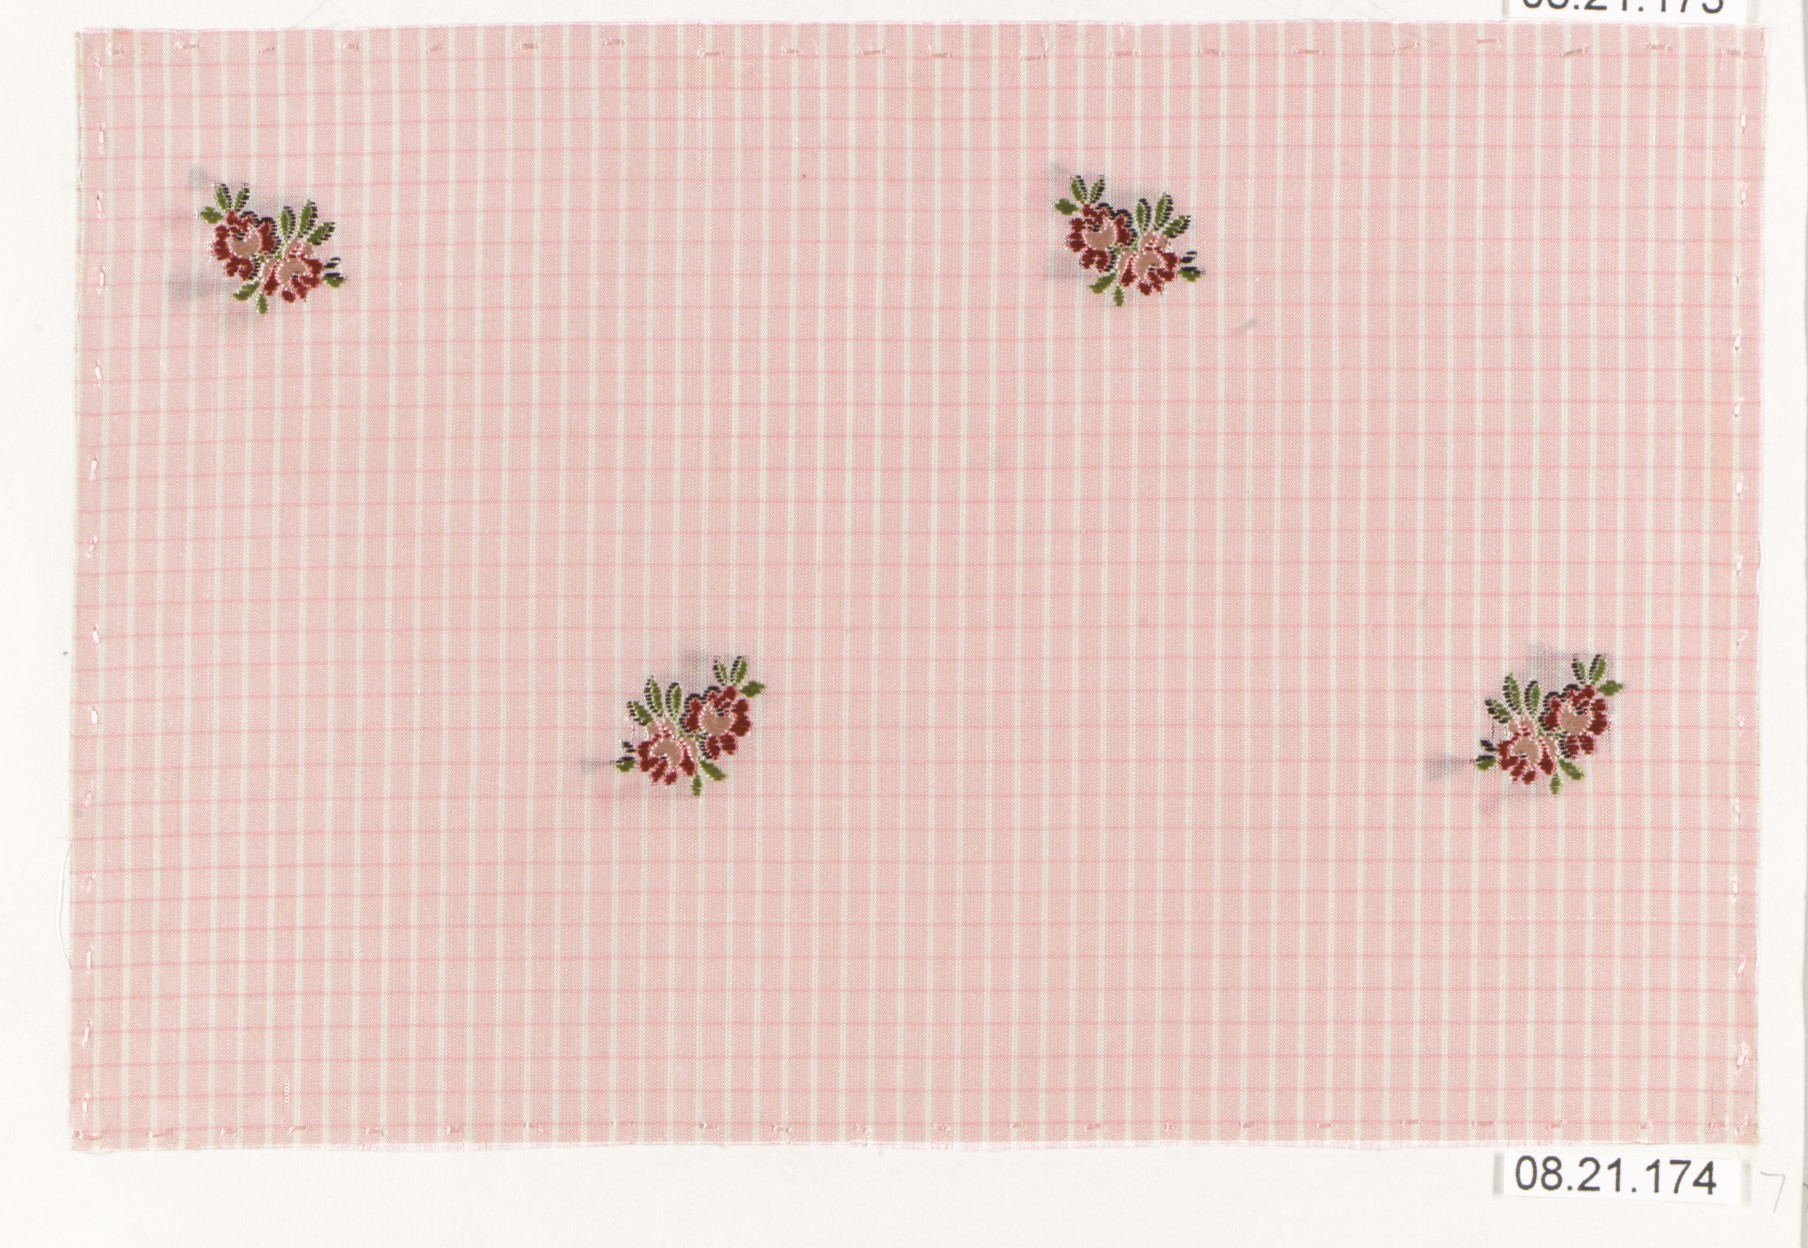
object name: textile sample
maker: Anonymous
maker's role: designer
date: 1900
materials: silk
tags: flowers